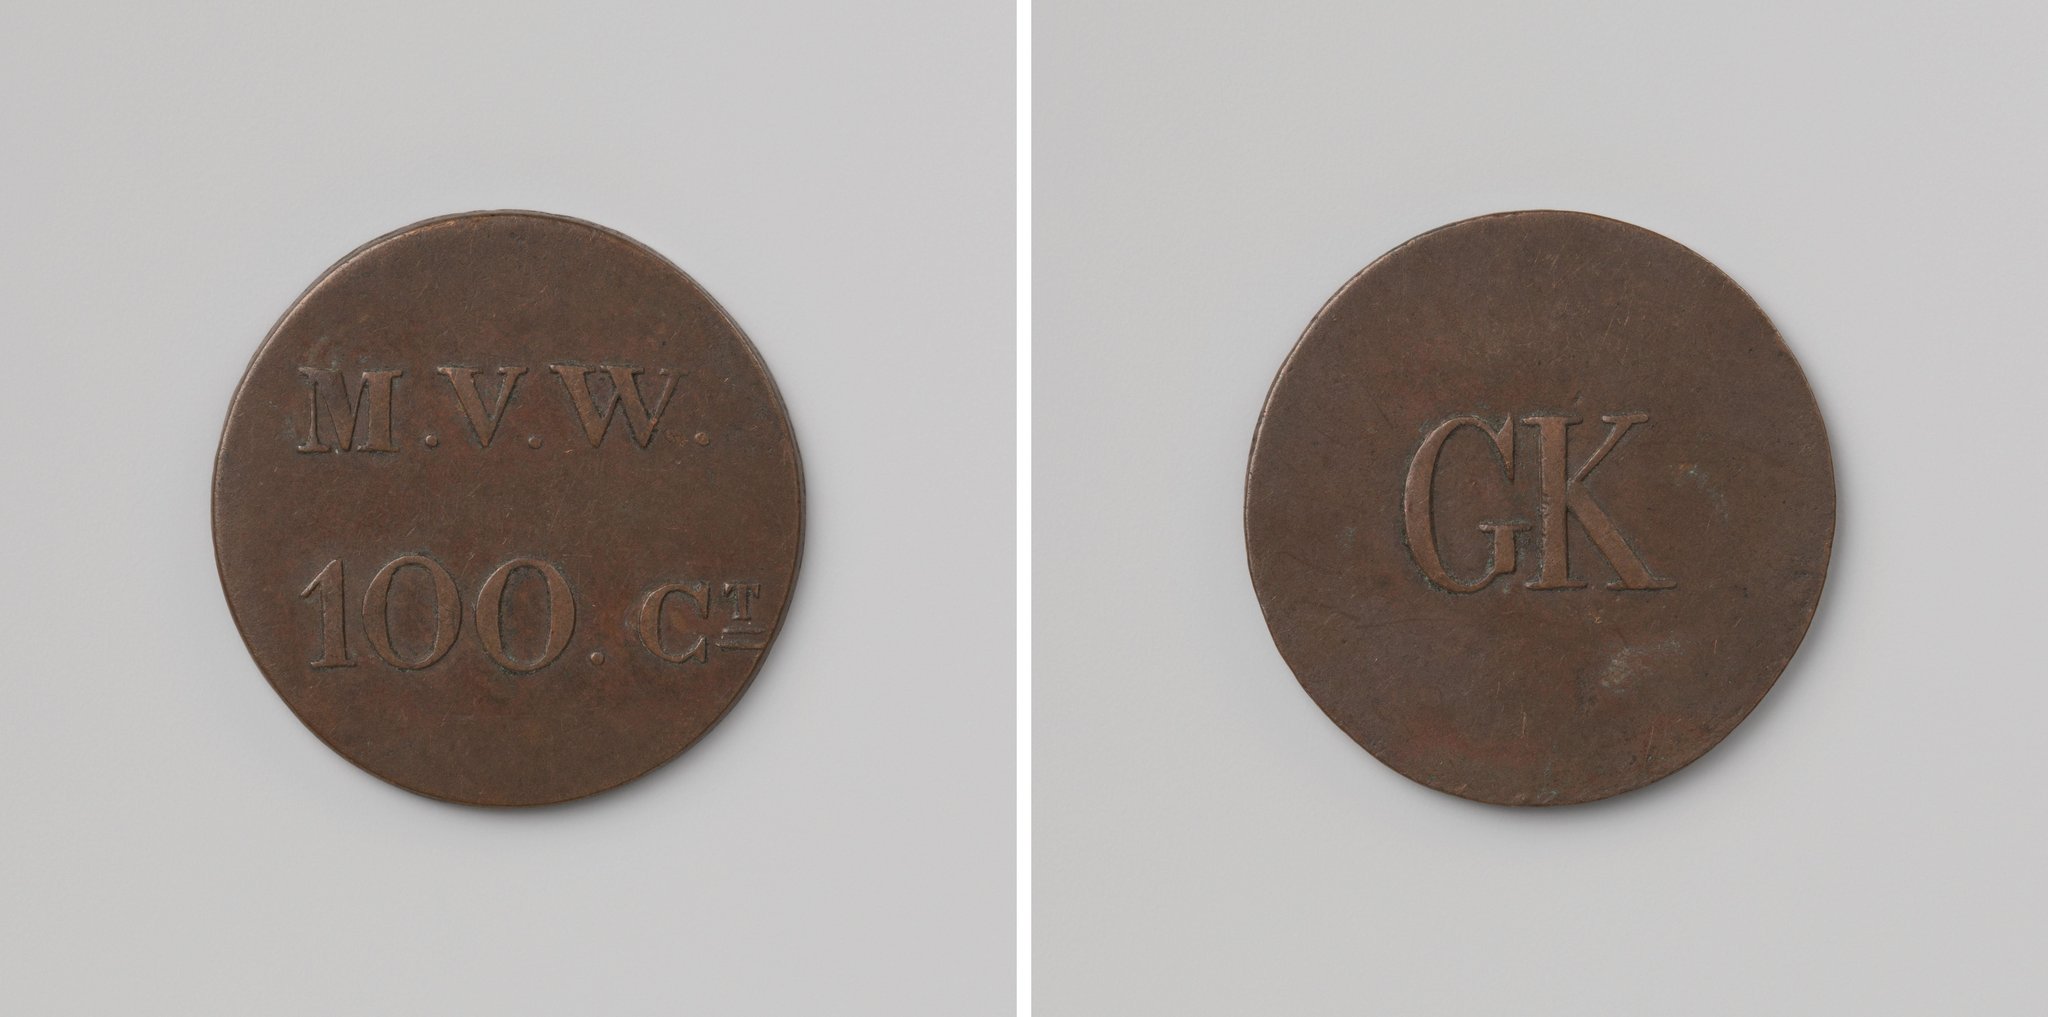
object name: monetary token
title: Huismunt geslagen op last van de Maatschappij van Weldadigheid ter waarde van 1 gulden, ten behoeve van de Gewone Koloniën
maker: Anonymous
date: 1818-1859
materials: copper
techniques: striking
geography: netherlands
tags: maatschappij van weldadigheid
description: Voorzijde: opschrift boven waardeaanduiding. Keerzijde: letters G en K